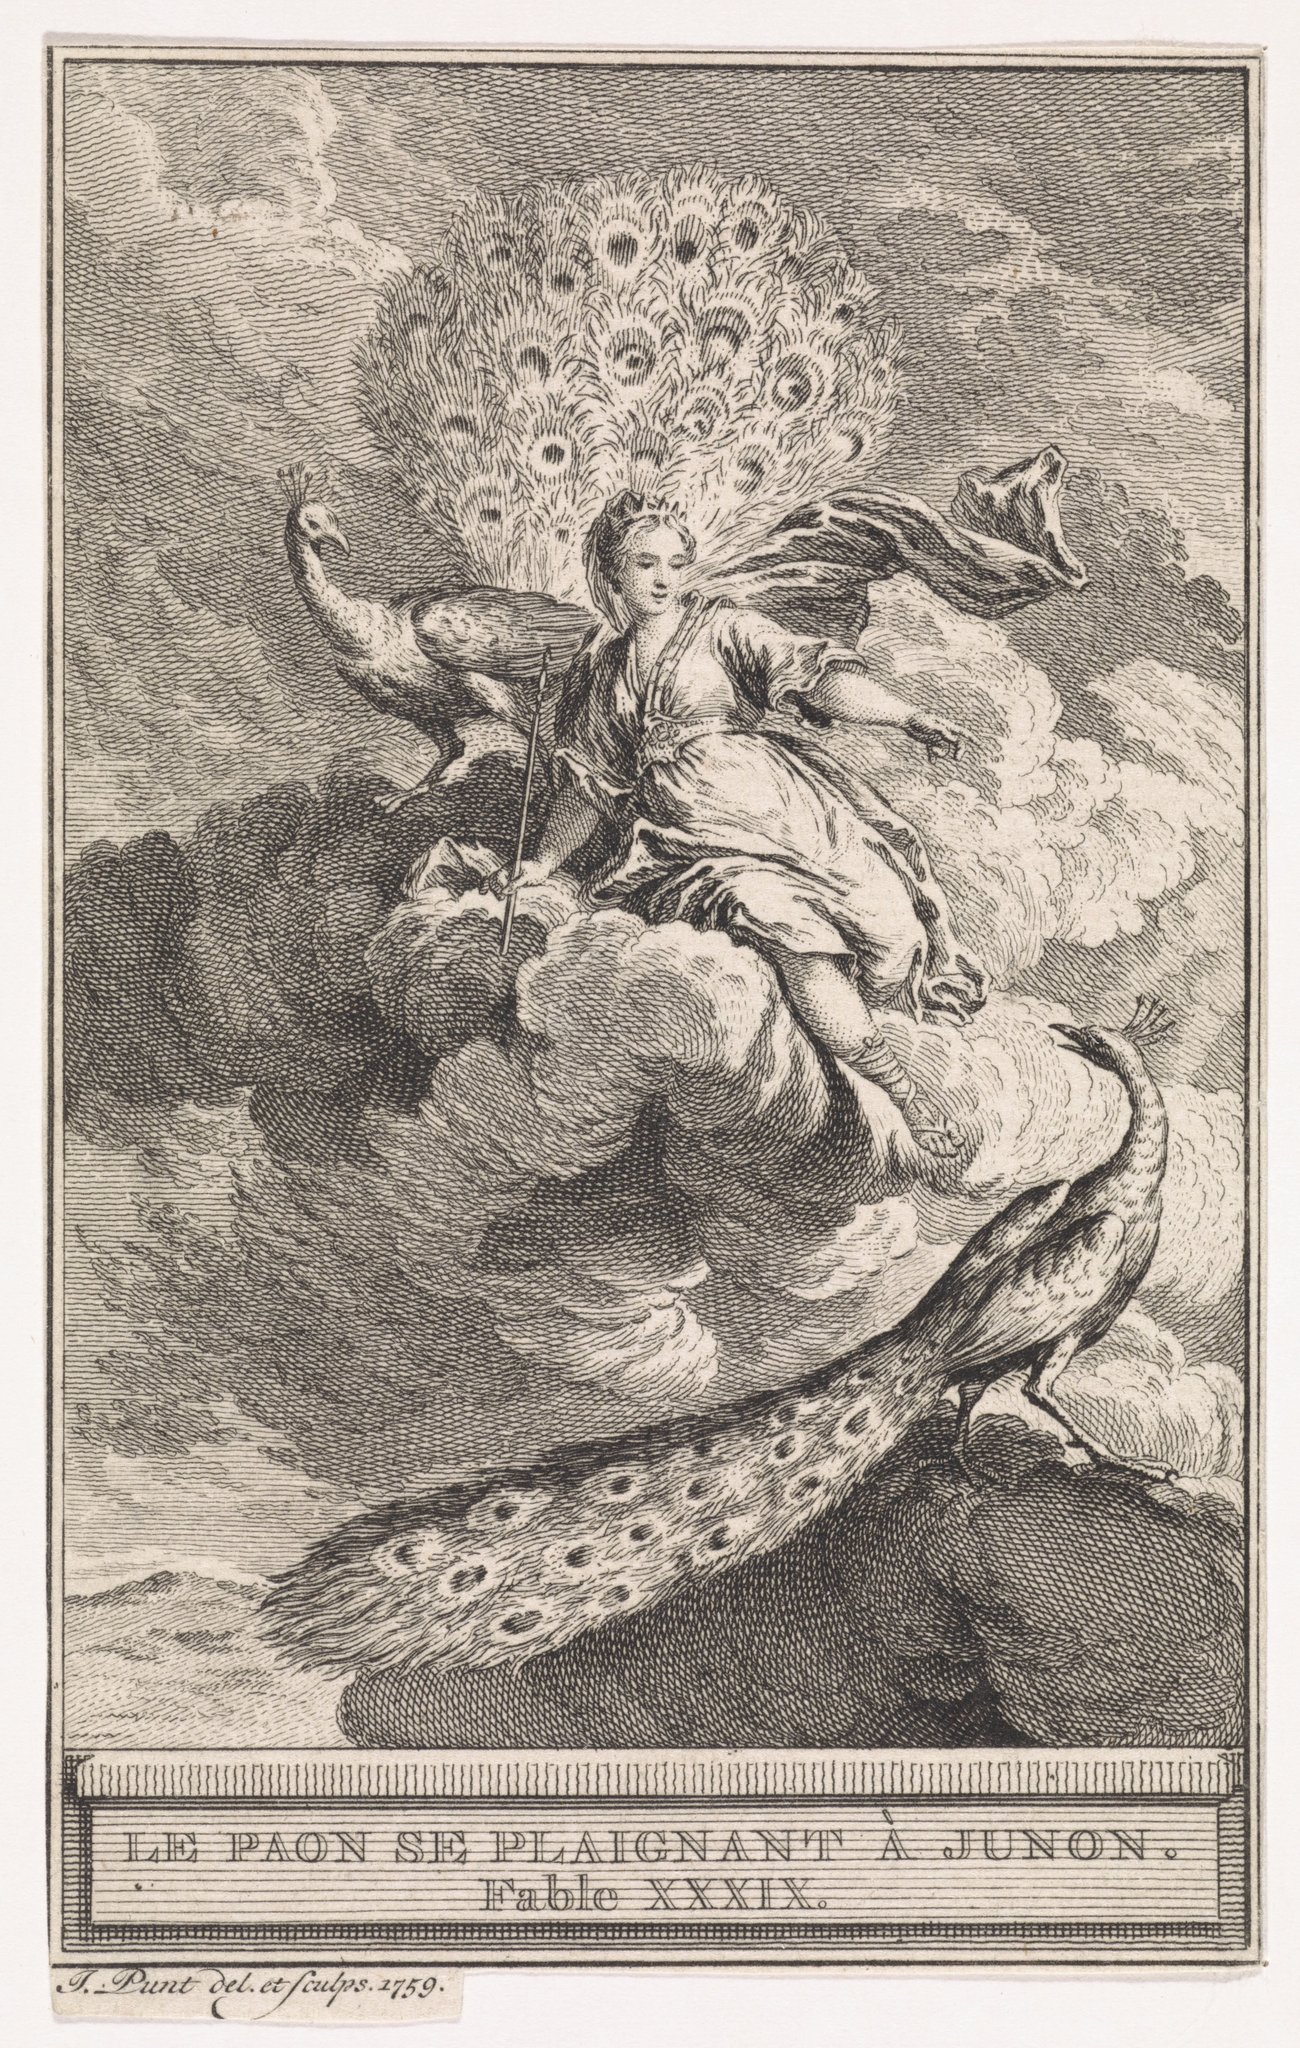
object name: print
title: Juno in de wolken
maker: jan punt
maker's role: draughtsman, print maker, publisher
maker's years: 1711-1779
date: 1759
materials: paper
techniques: engraving, etching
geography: amsterdam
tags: (story of) juno (hera), ornamental birds: peacock, specific works of literature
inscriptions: collector's mark: Lugt 2228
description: Prent gebruikt als illustratie in een of meerdere edities van: La Fontaine, Jean de. Fables choisies, deel I, p. 70. Leiden: Elie Luzac, 1764-1786. En in de editie uit Amsterdam: J. van Gulik, 1802.